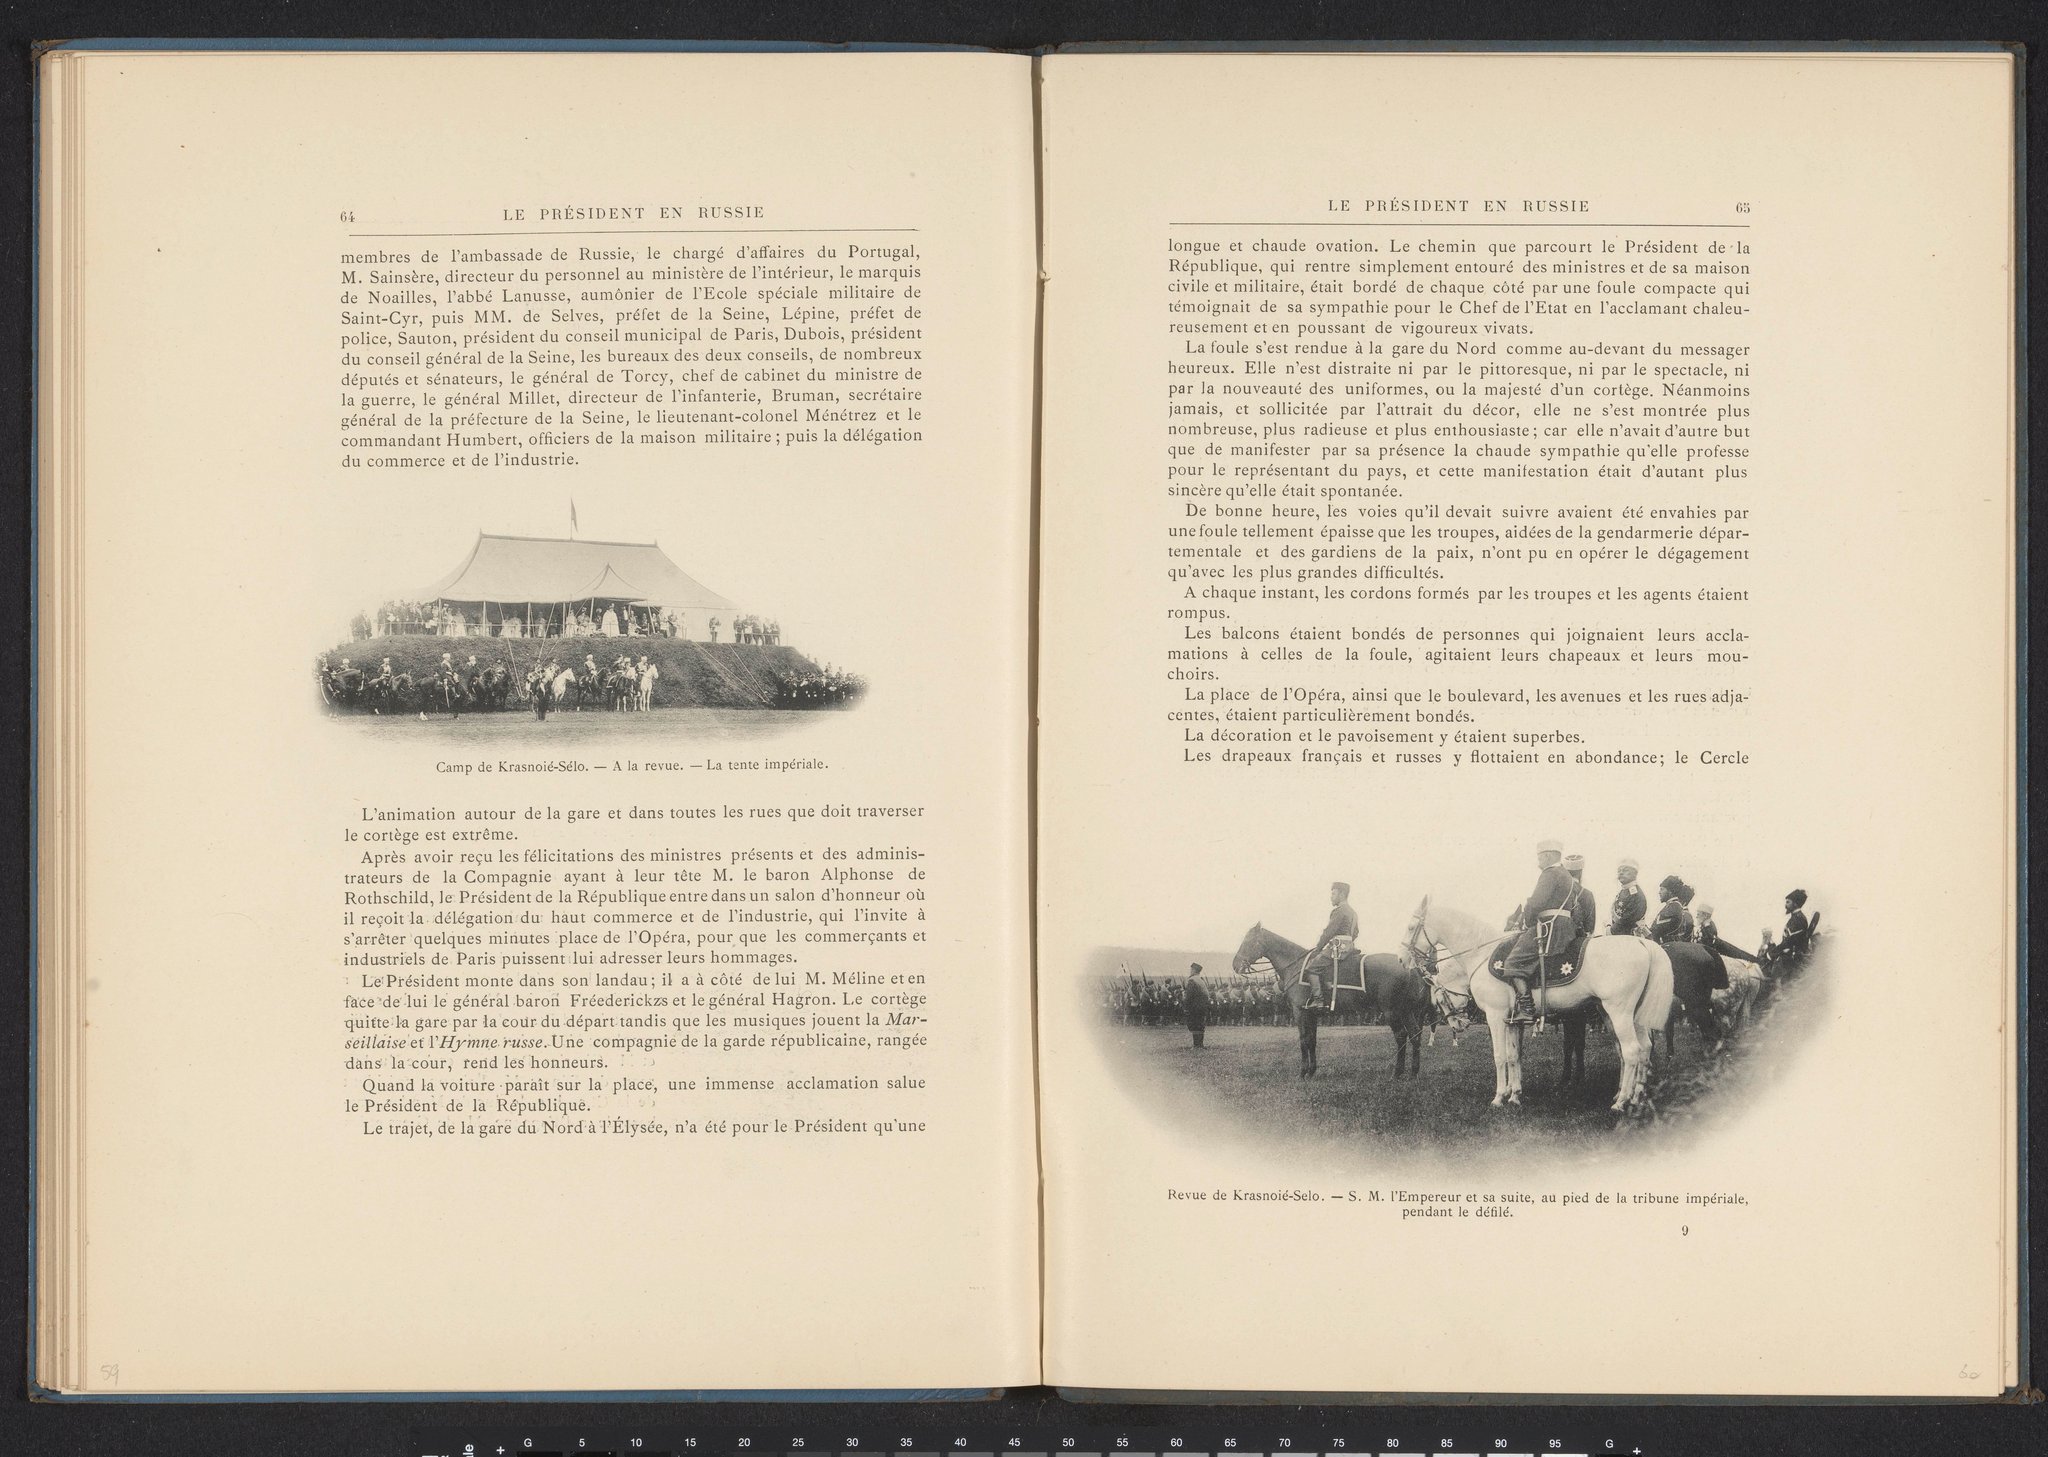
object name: page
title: Tsaar Nicolaas II van Rusland en zijn gevolg te paard te Krasnoye Selo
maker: Anonymous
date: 1897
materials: paper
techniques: photograph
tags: riding a horse, ass, or mule; rider, horseman, ruler, sovereign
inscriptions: inscription: ‘Revue de Krasnoié-Sélo-(...) le défilé.’